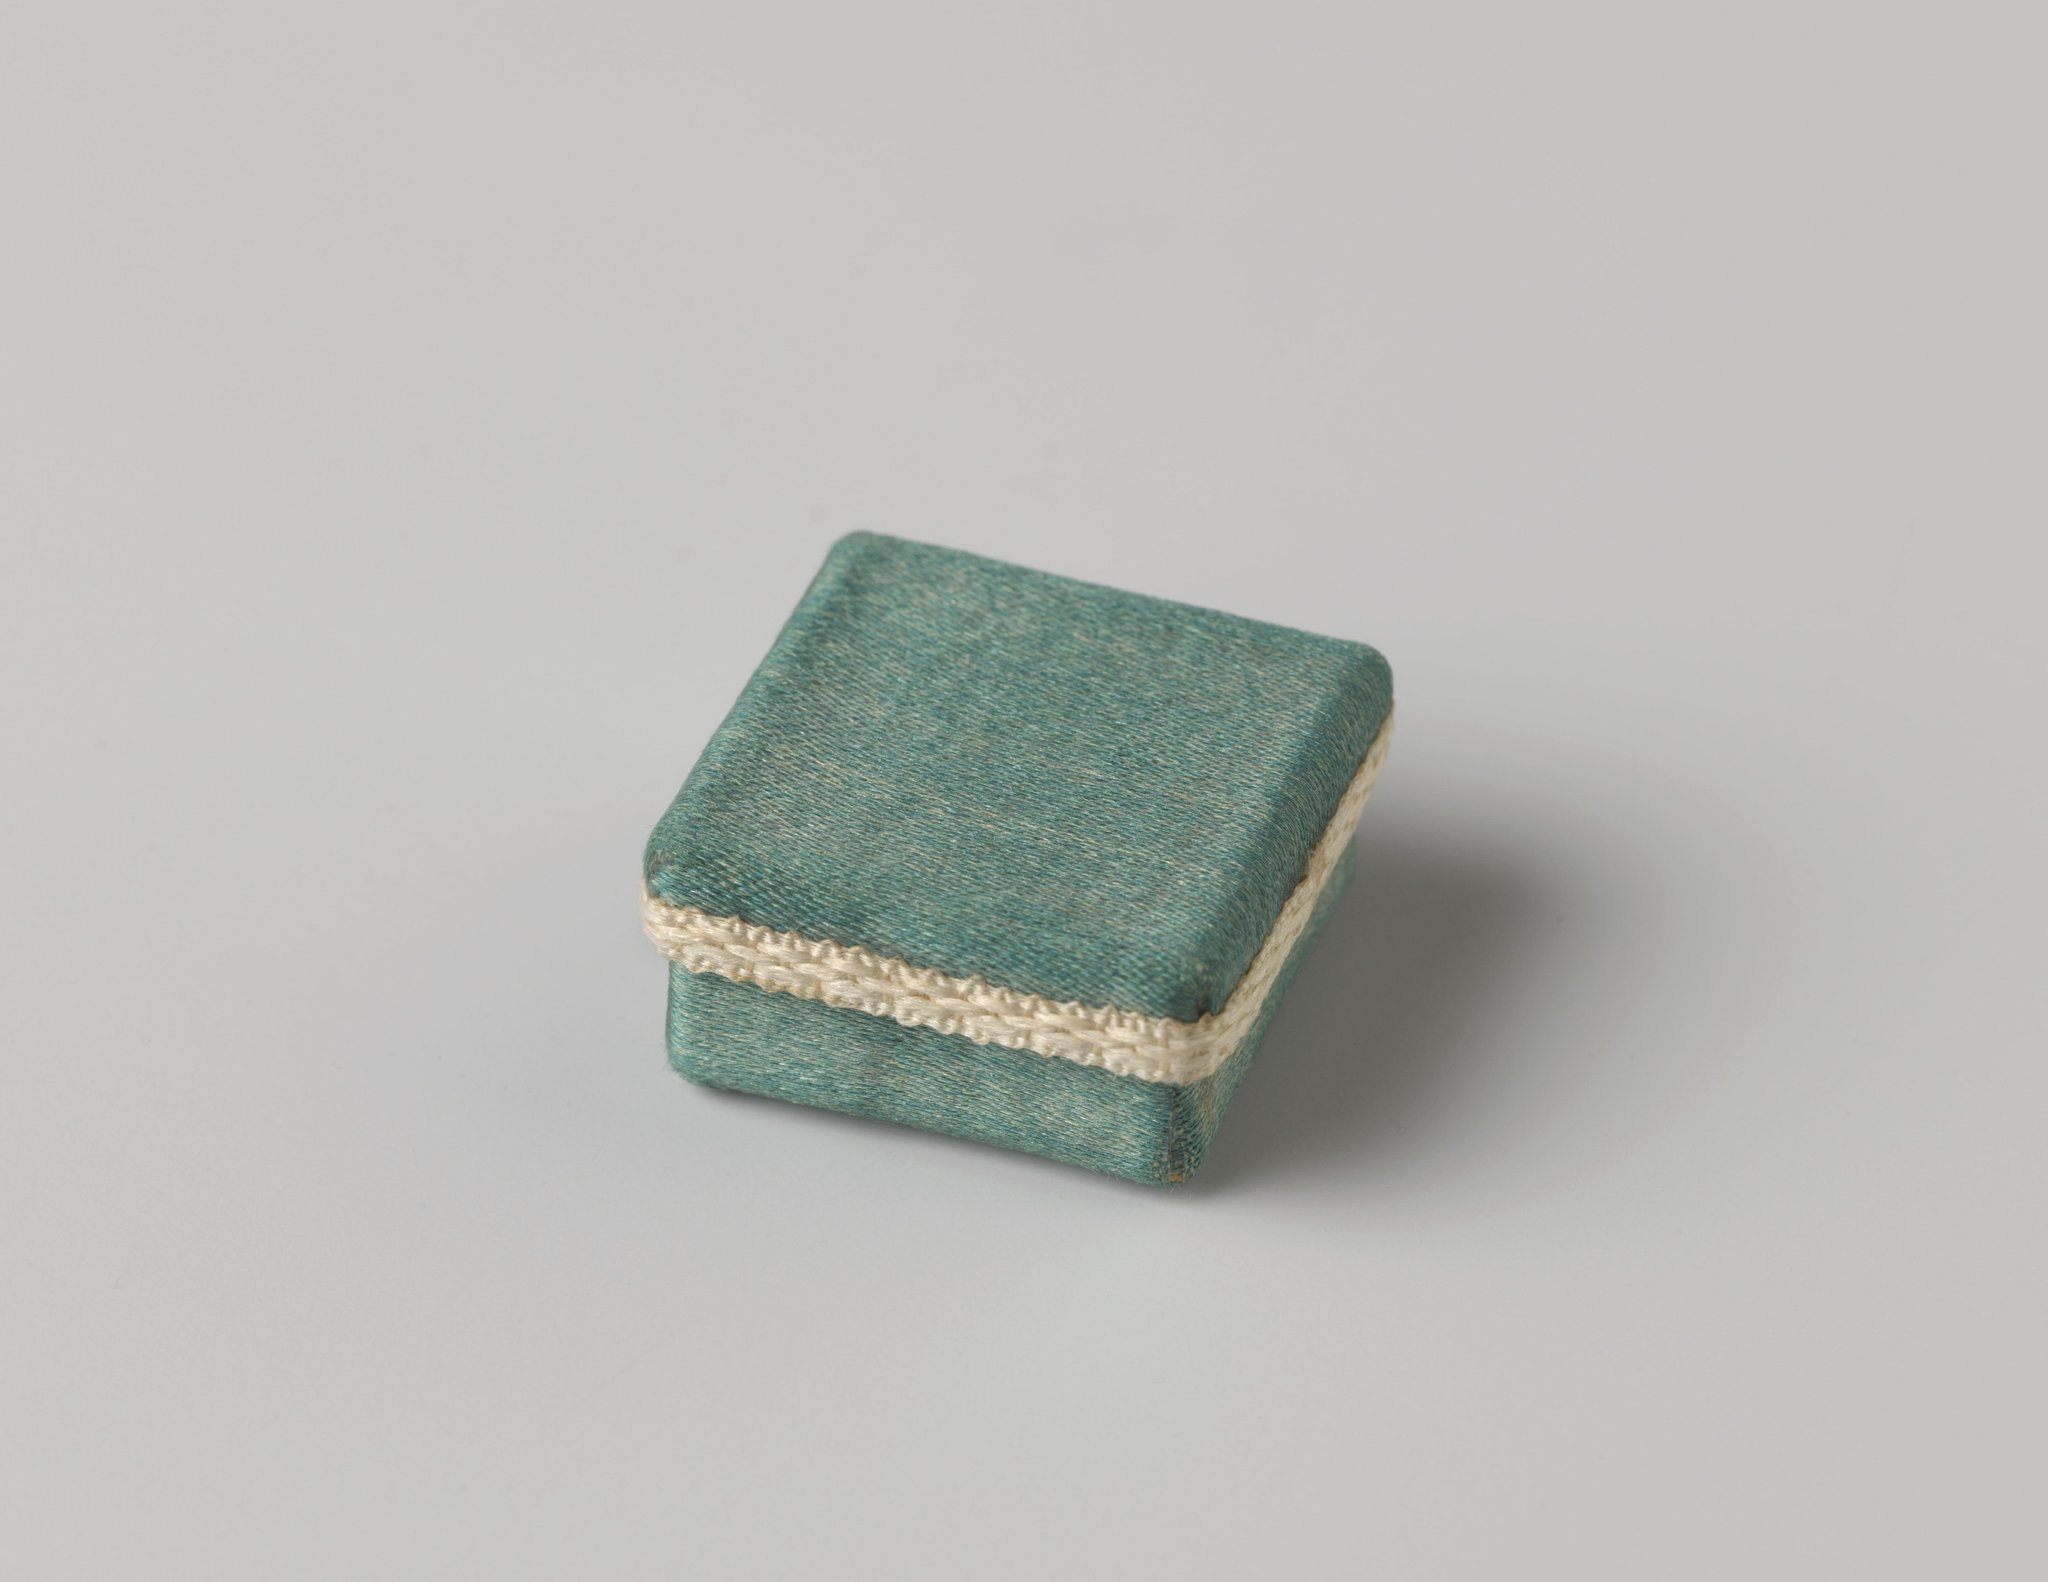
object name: box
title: Doos met deksel, vierkant, overtrokken met blauw-groene zijde en afgezet met wit band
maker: Anonymous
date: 1750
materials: board, silk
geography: amsterdam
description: Doos met deksel, vierkant, overtrokken met blauw-groene zijde (satijn). Het deksel is afgezet met een wit zijden band. De onderkant van de doos is beplakt met blauwe zijde (ribs). In de doos bevindt zich een oranje roset (zijden band) met metalen paillet.